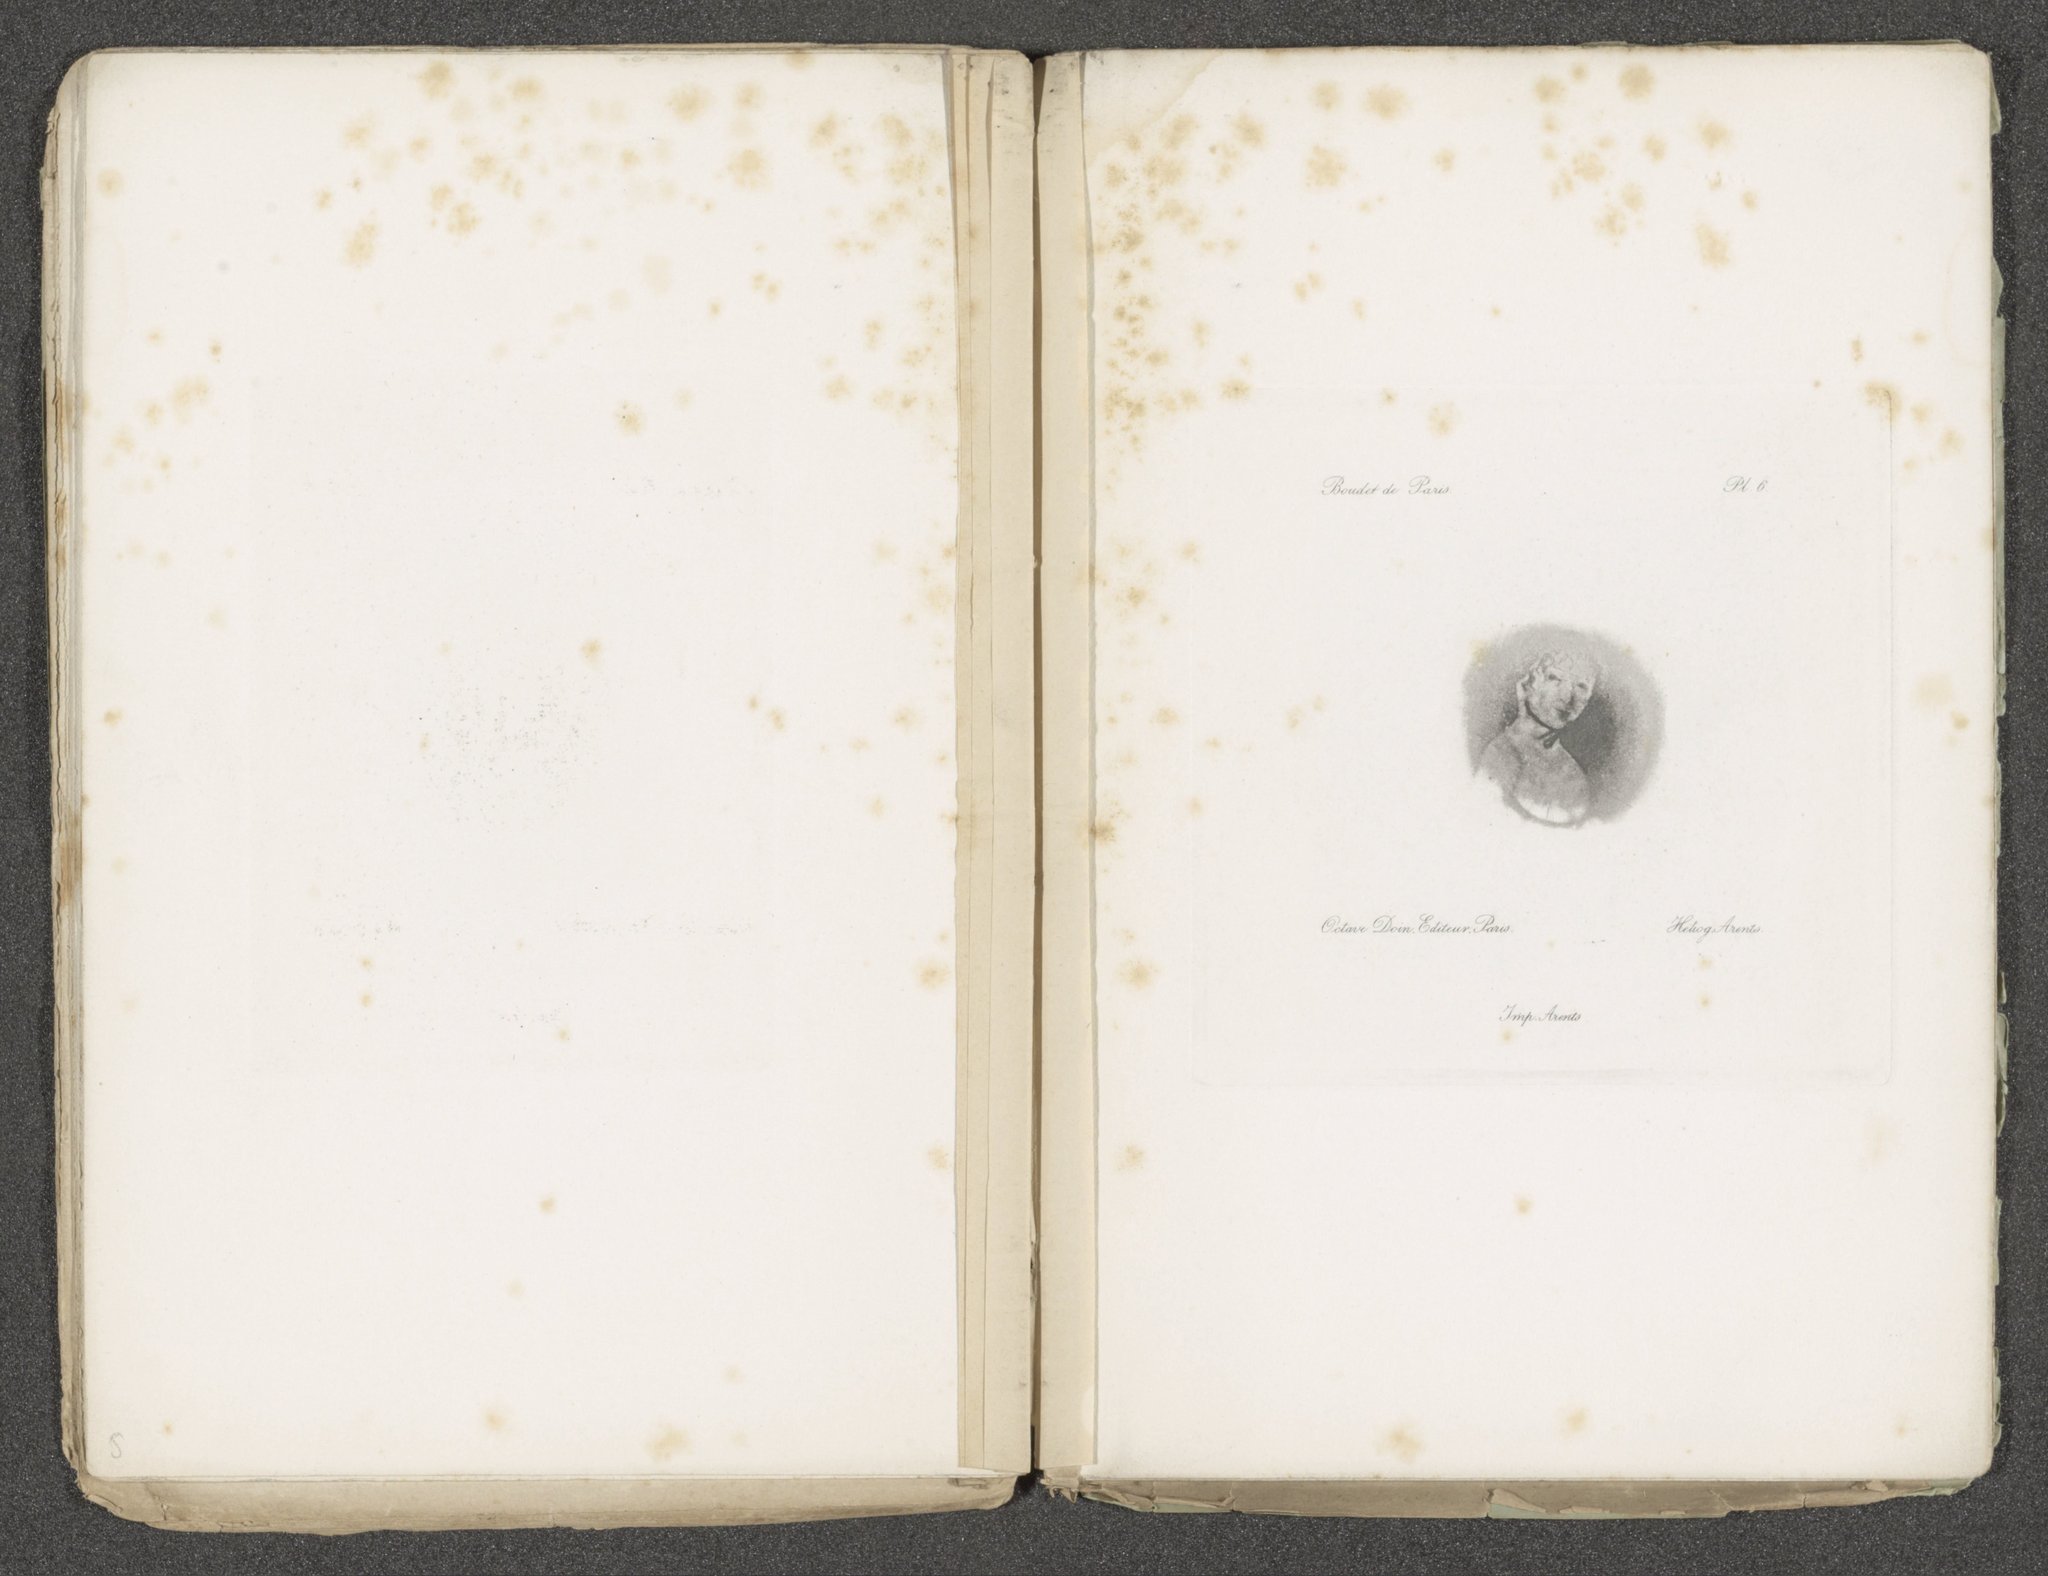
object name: reproduction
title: Fotoreproductie van een tekening, voorstellende een portret van een onbekende vrouw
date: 1876-1886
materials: paper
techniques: photoaquatint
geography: paris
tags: anonymous historical person portrayed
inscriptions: number: ‘Pl. 6.’